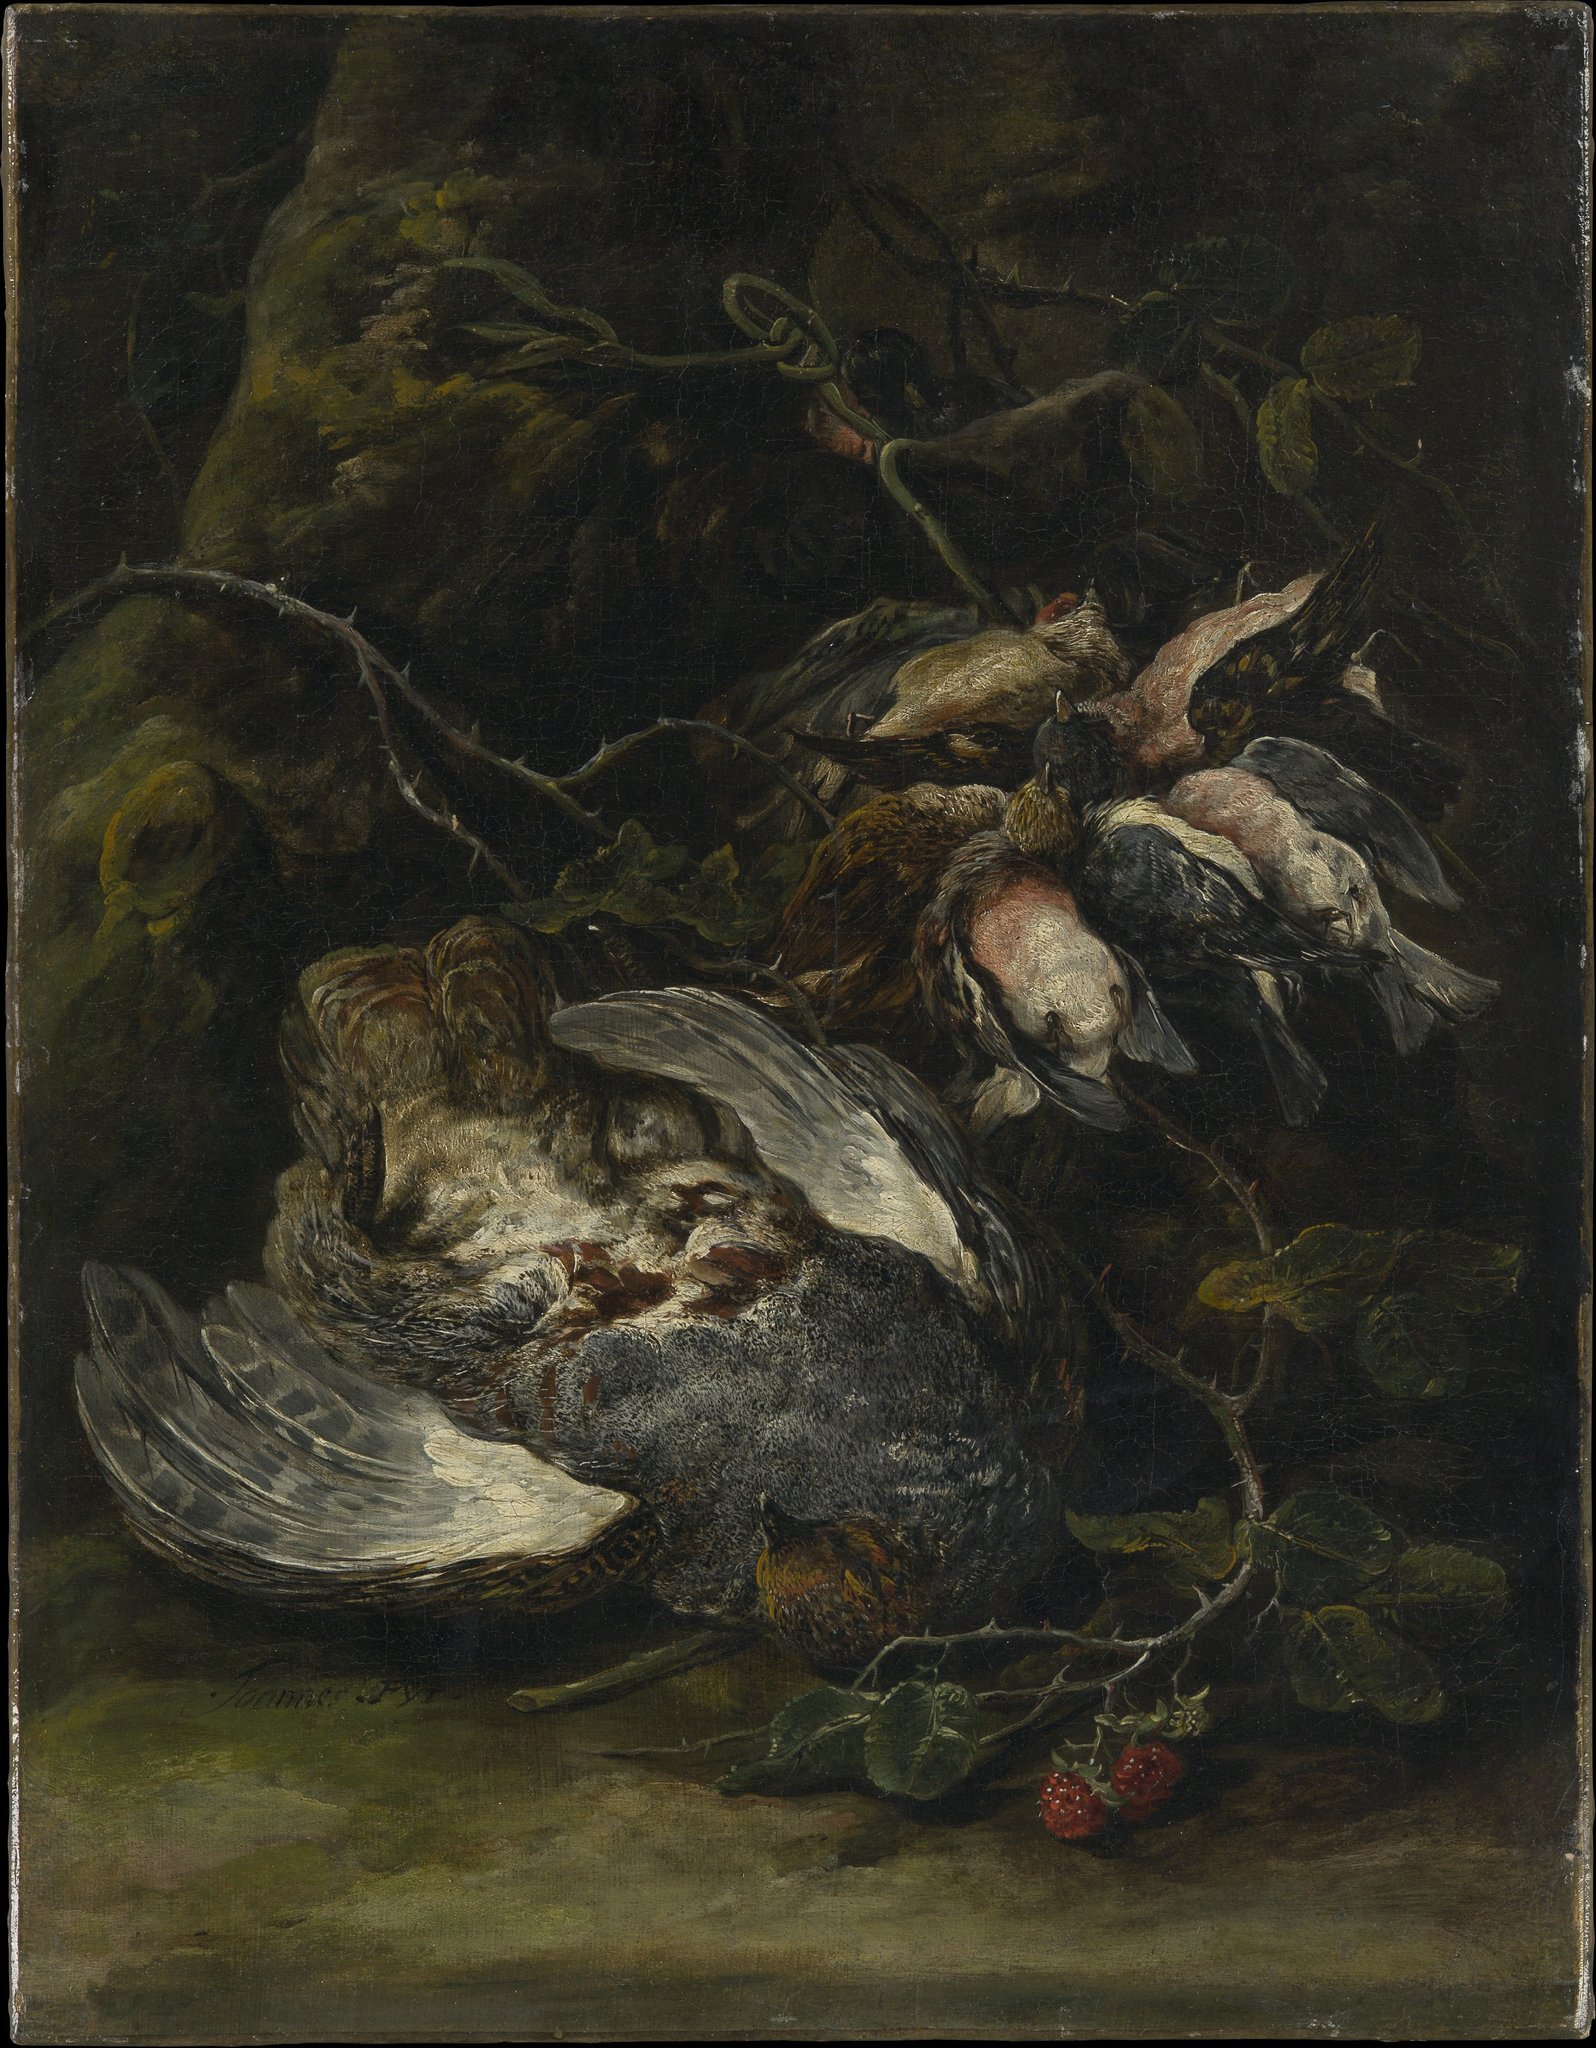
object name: painting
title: A Partridge and Small Game Birds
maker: jan fyt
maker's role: artist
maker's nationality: flemish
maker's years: 1611-1661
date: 1650-1659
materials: canvas, oil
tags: birds,still life